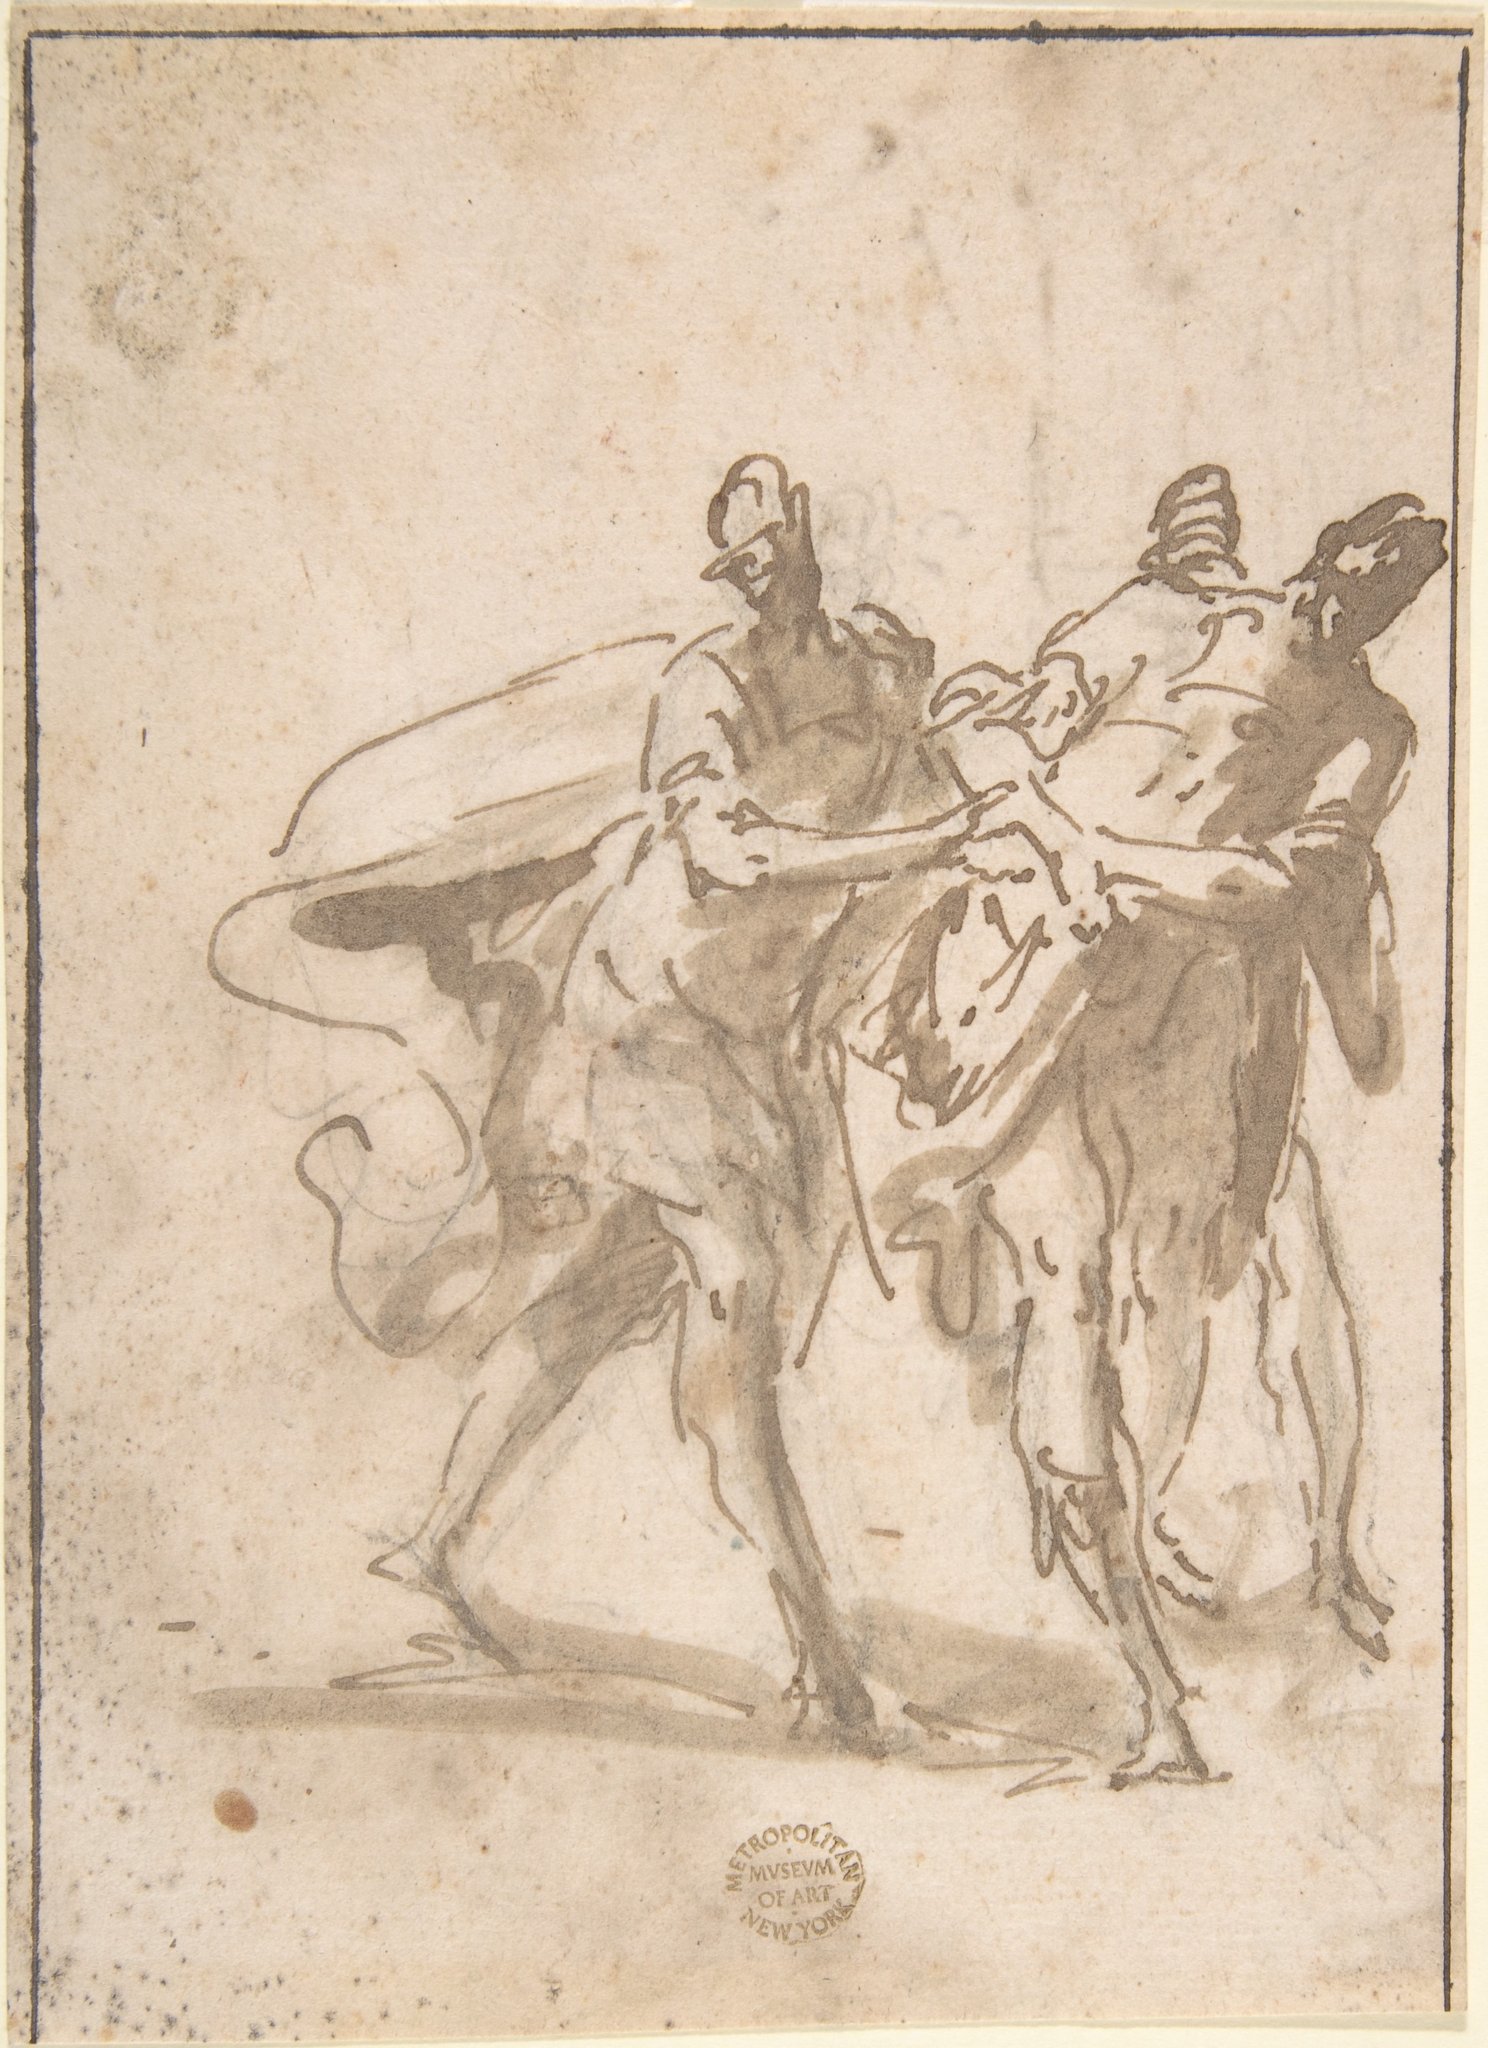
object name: drawing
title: Three Figures (recto); Sketches of Kneeling Figures and Putti (verso)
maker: domenico mondo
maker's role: artist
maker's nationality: italian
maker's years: 1732-1806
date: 1760-1806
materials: chalk, ink, paper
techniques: brush, pen, wash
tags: human figures